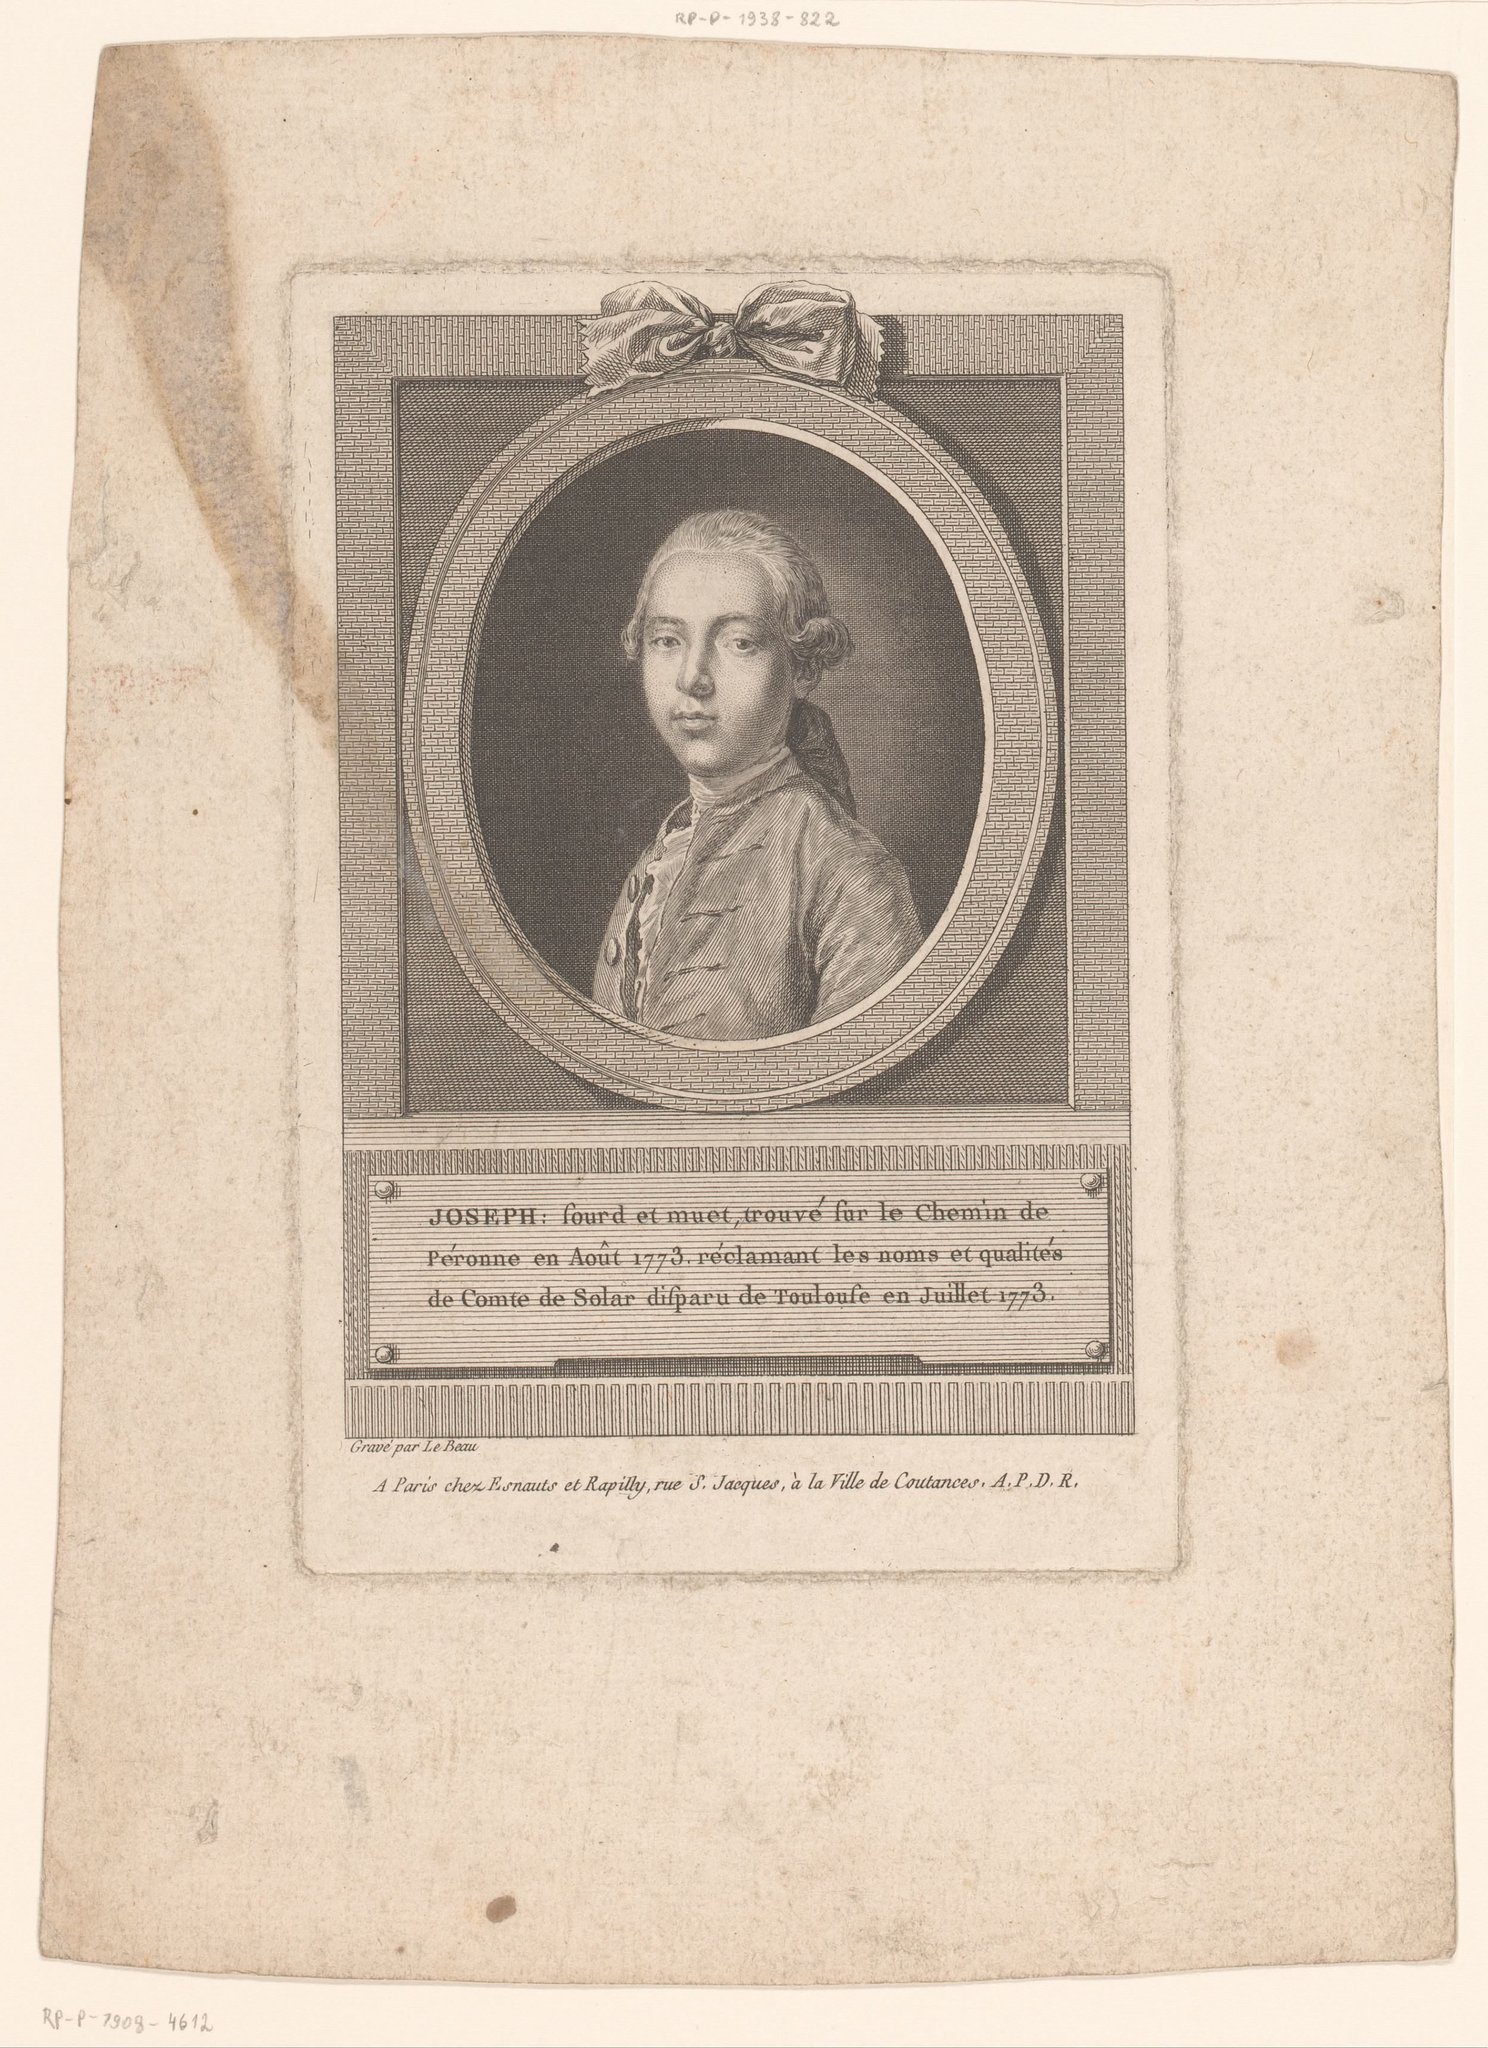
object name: print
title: Portret van mijnheer Joseph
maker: pierre adrien le beau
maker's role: draughtsman, print maker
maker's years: 1748-1806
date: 1773-1806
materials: paper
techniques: engraving, etching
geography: paris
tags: ornament ~ medallion, historical persons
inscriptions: collector's mark: Lugt 2228